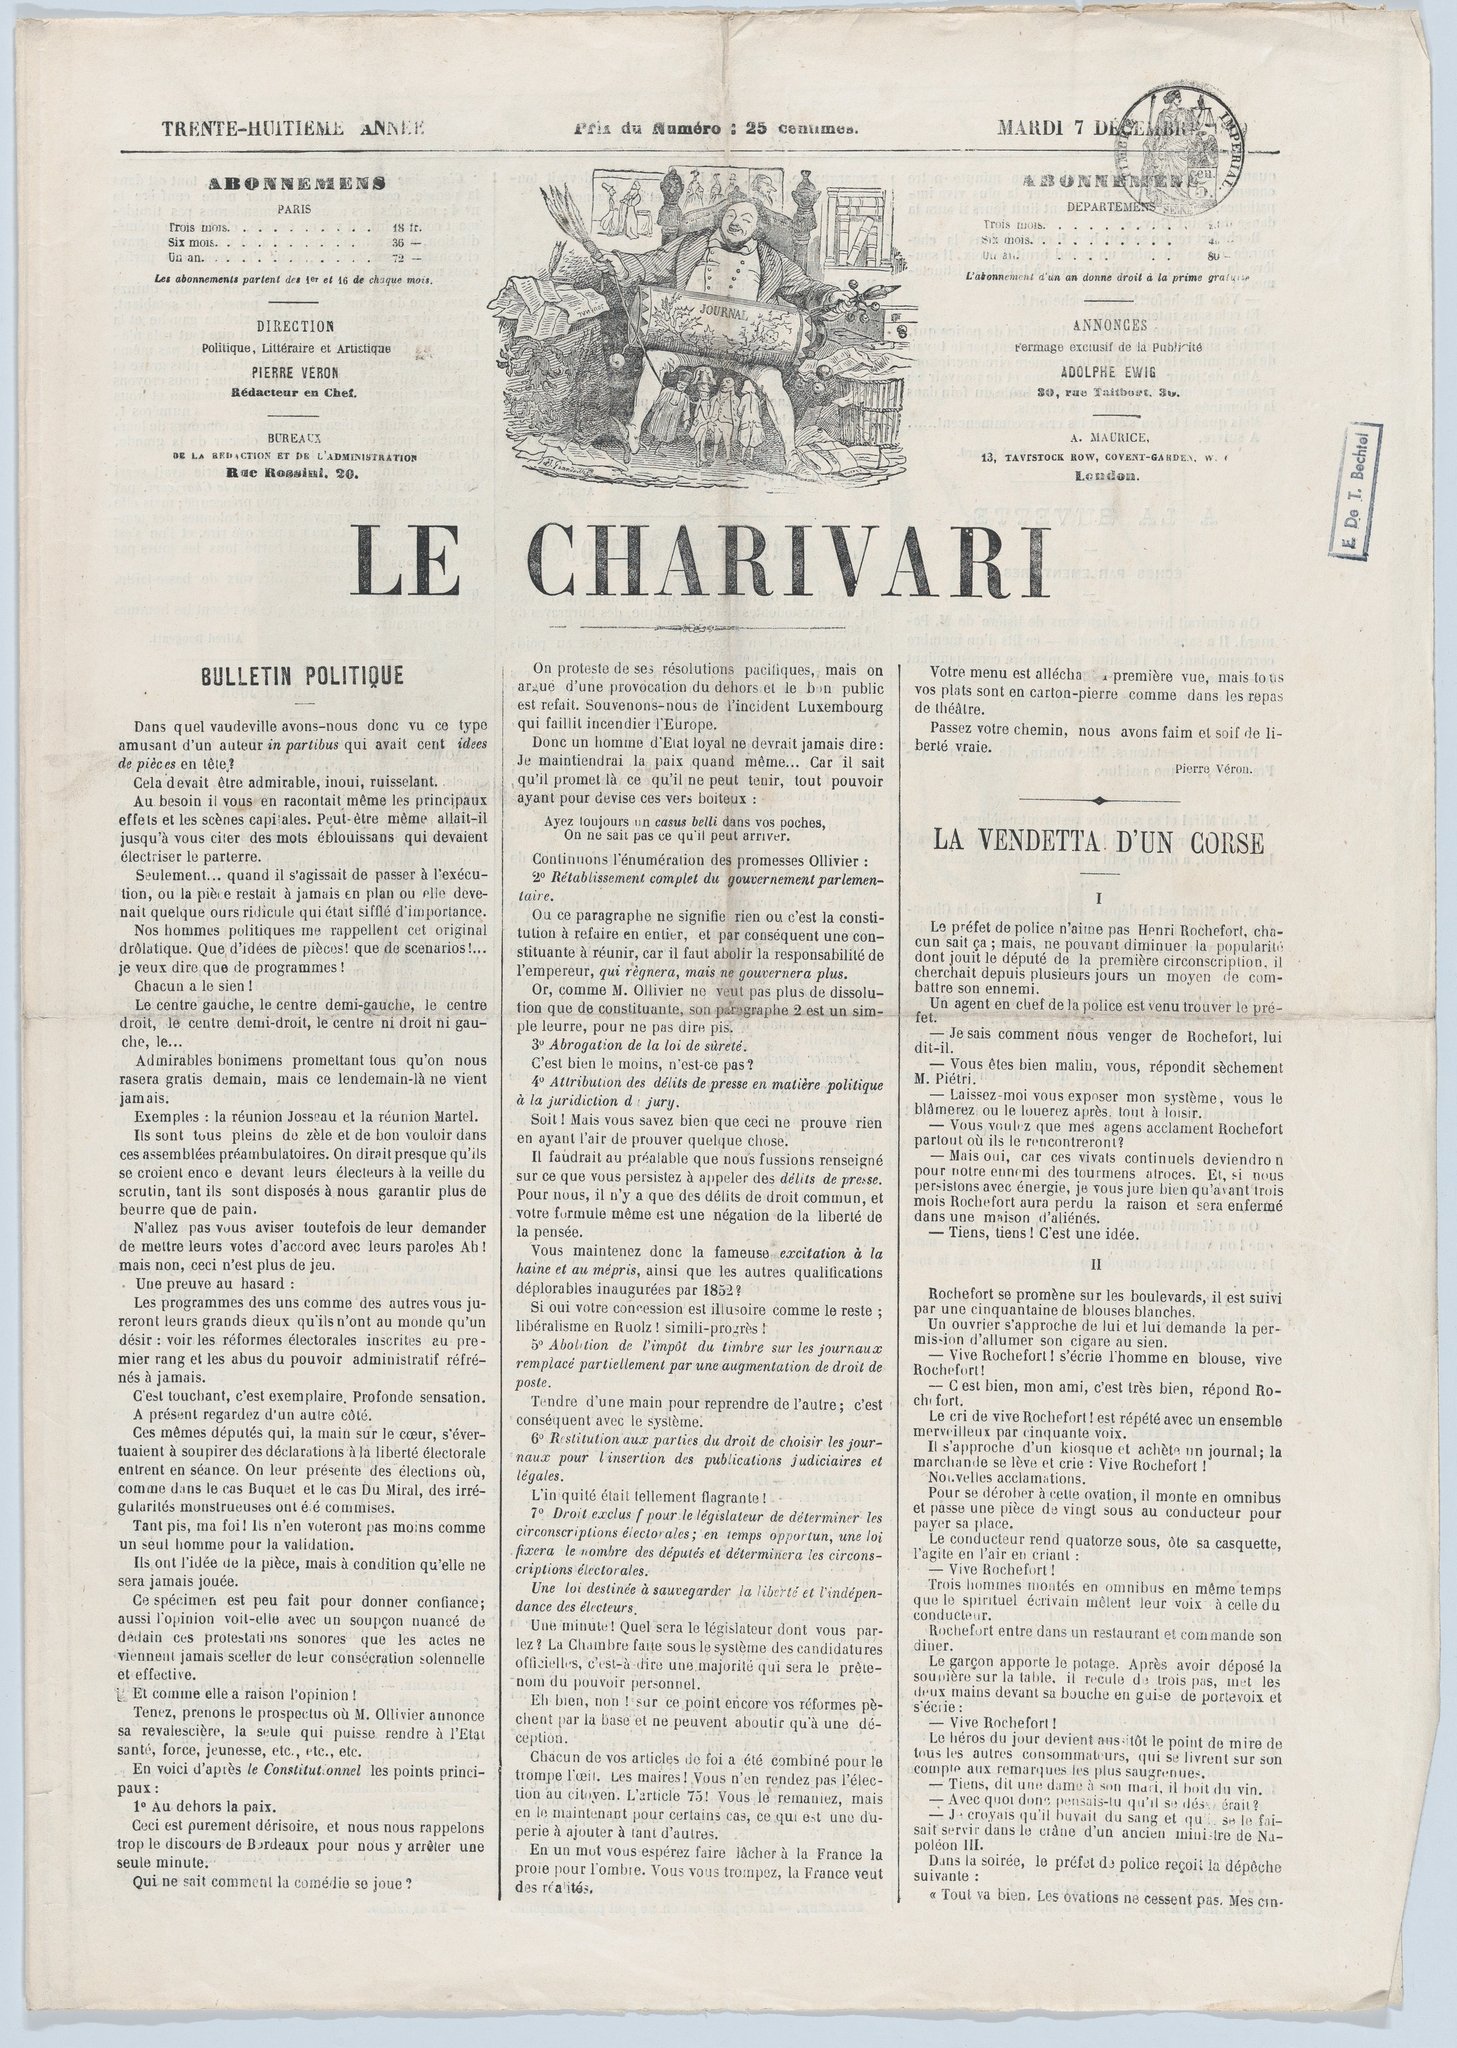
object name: print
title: A deputy's nightmare: – Oh my friend, what has happened? – I dreamed I was invalidated, from "News of the day"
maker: honoré daumier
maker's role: artist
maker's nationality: french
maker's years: 1808-1879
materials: paper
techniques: lithograph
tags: men